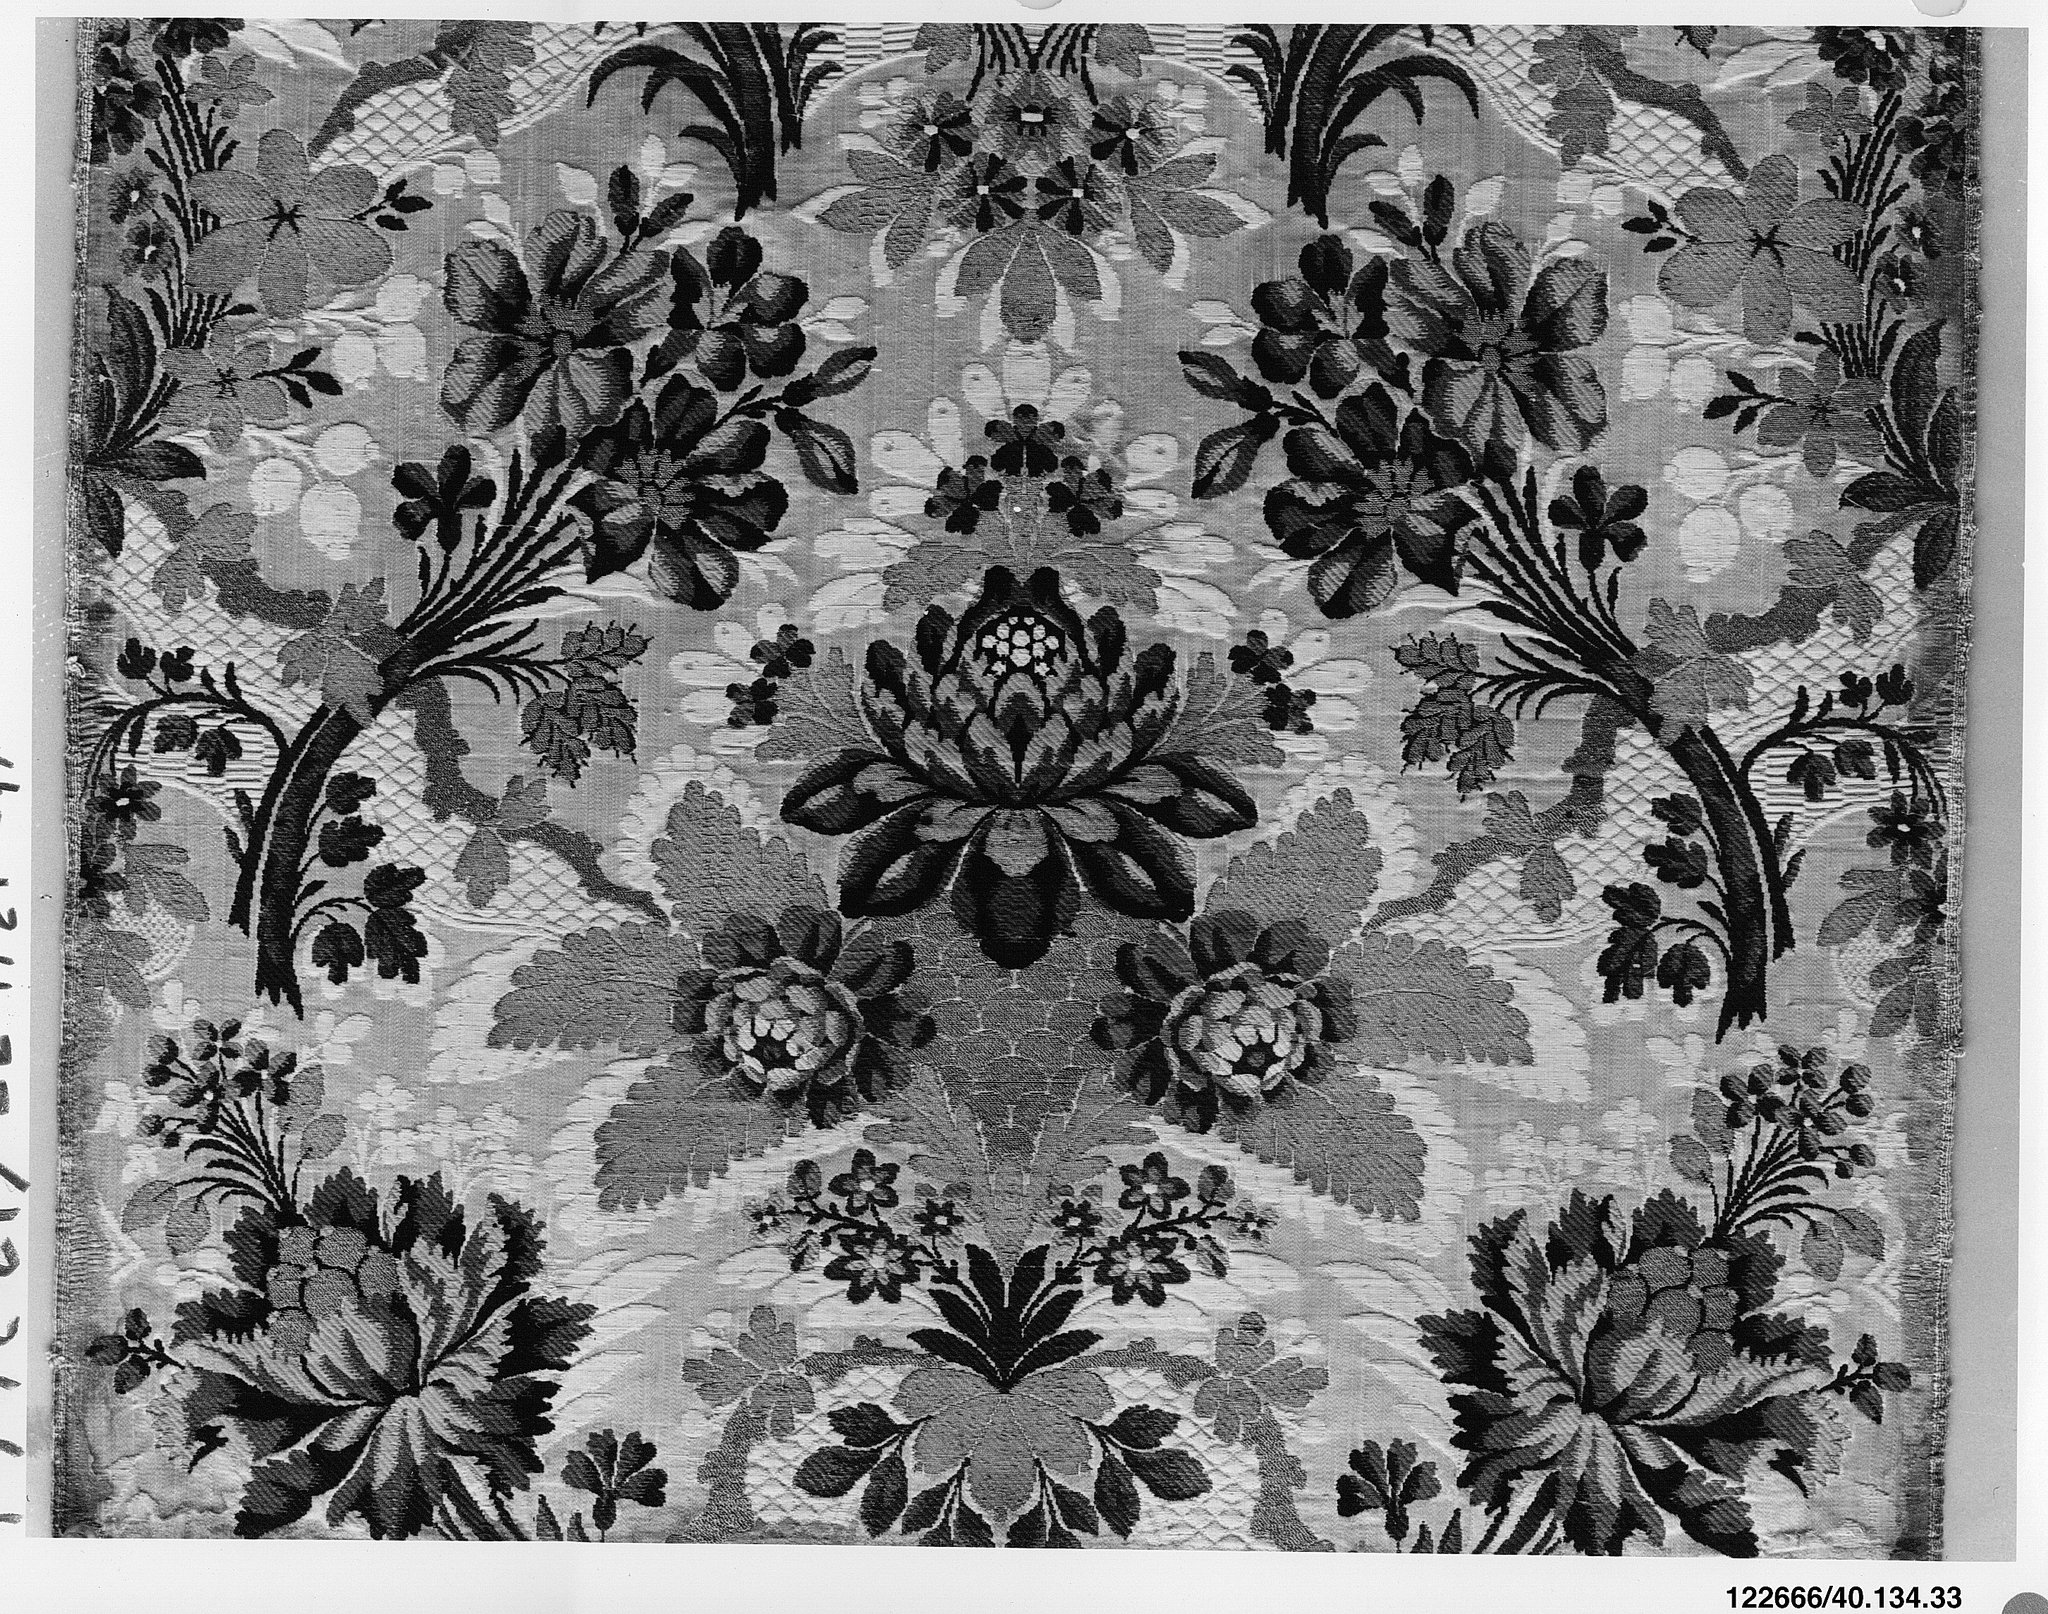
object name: piece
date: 1801-1833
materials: metal thread, silk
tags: flowers,leaves